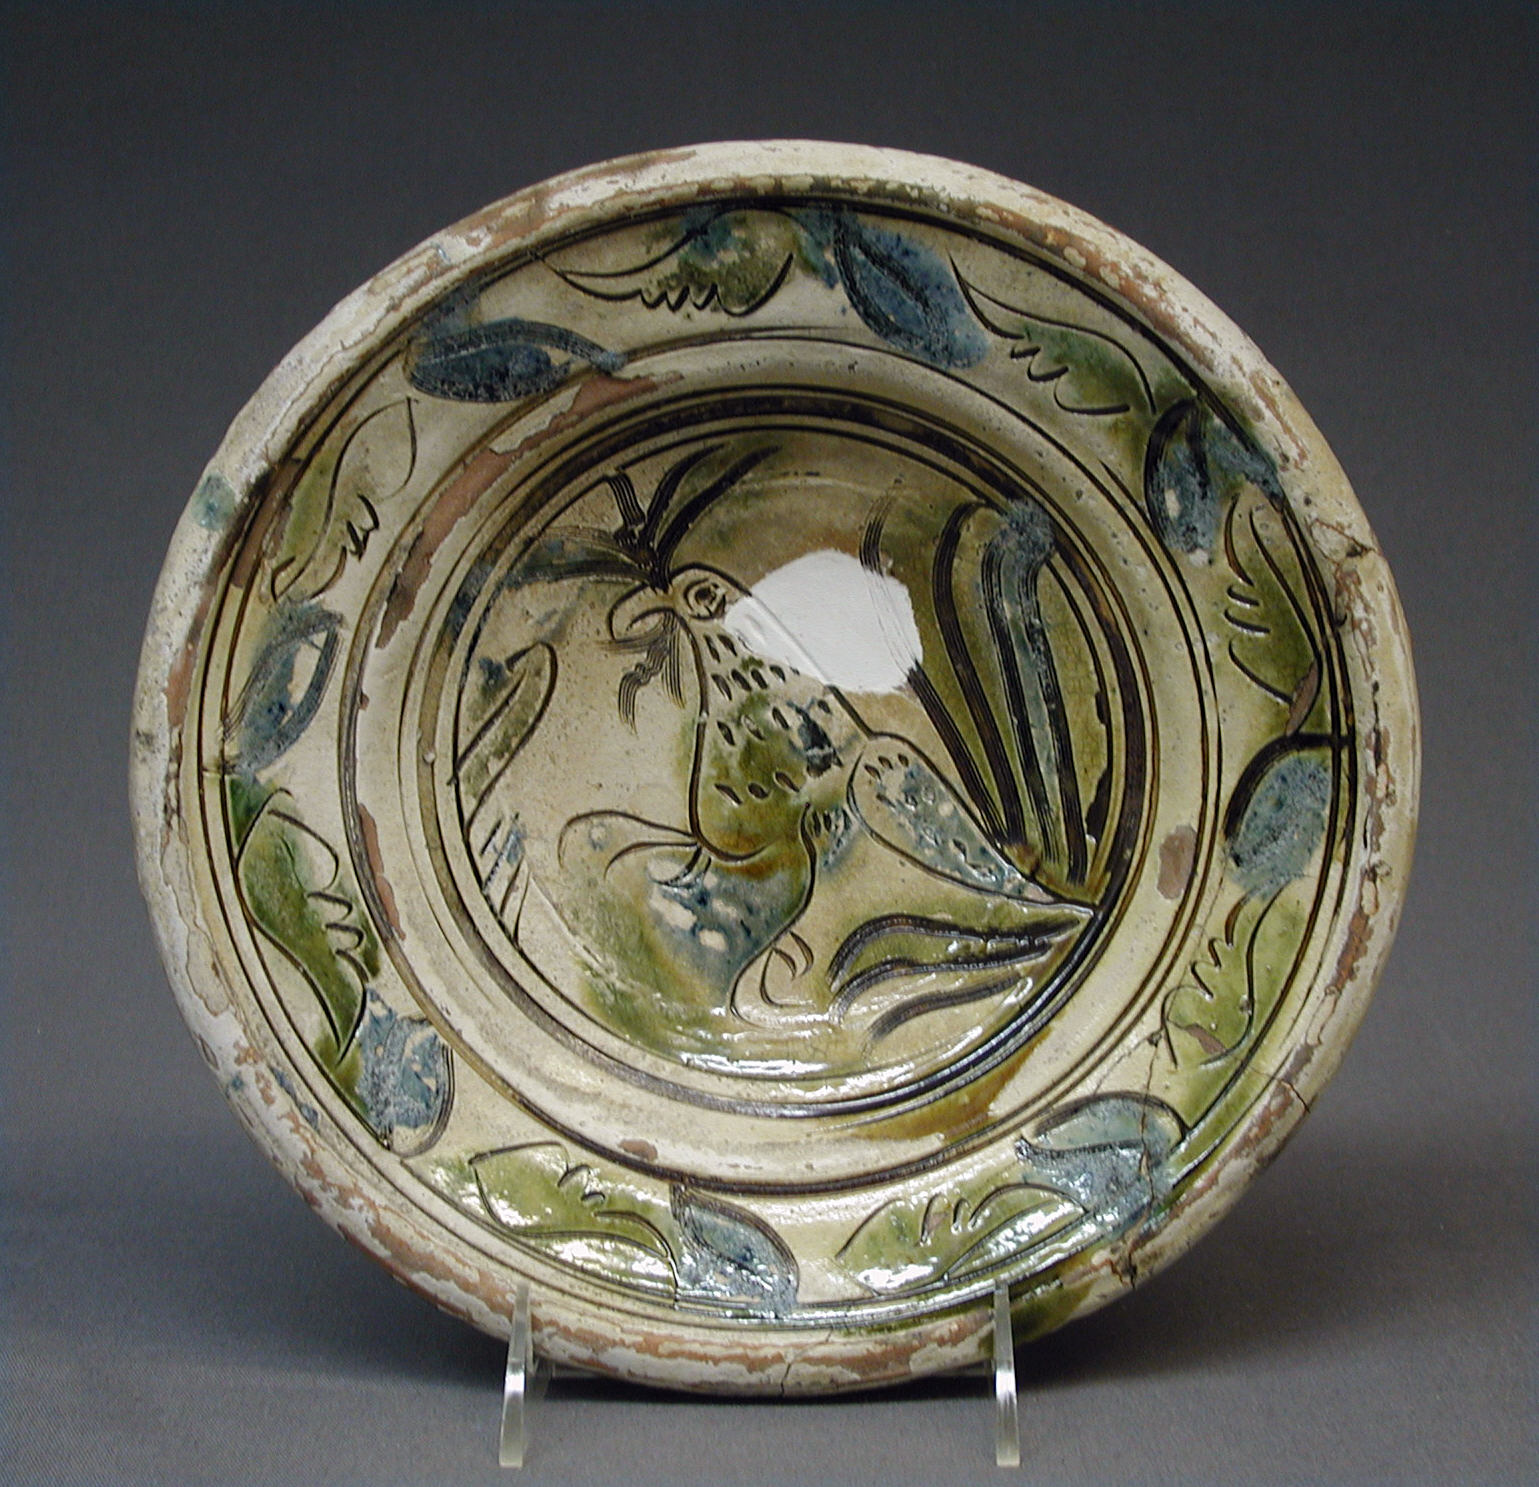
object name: dish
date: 1667-1733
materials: earthenware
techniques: glazing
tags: birds